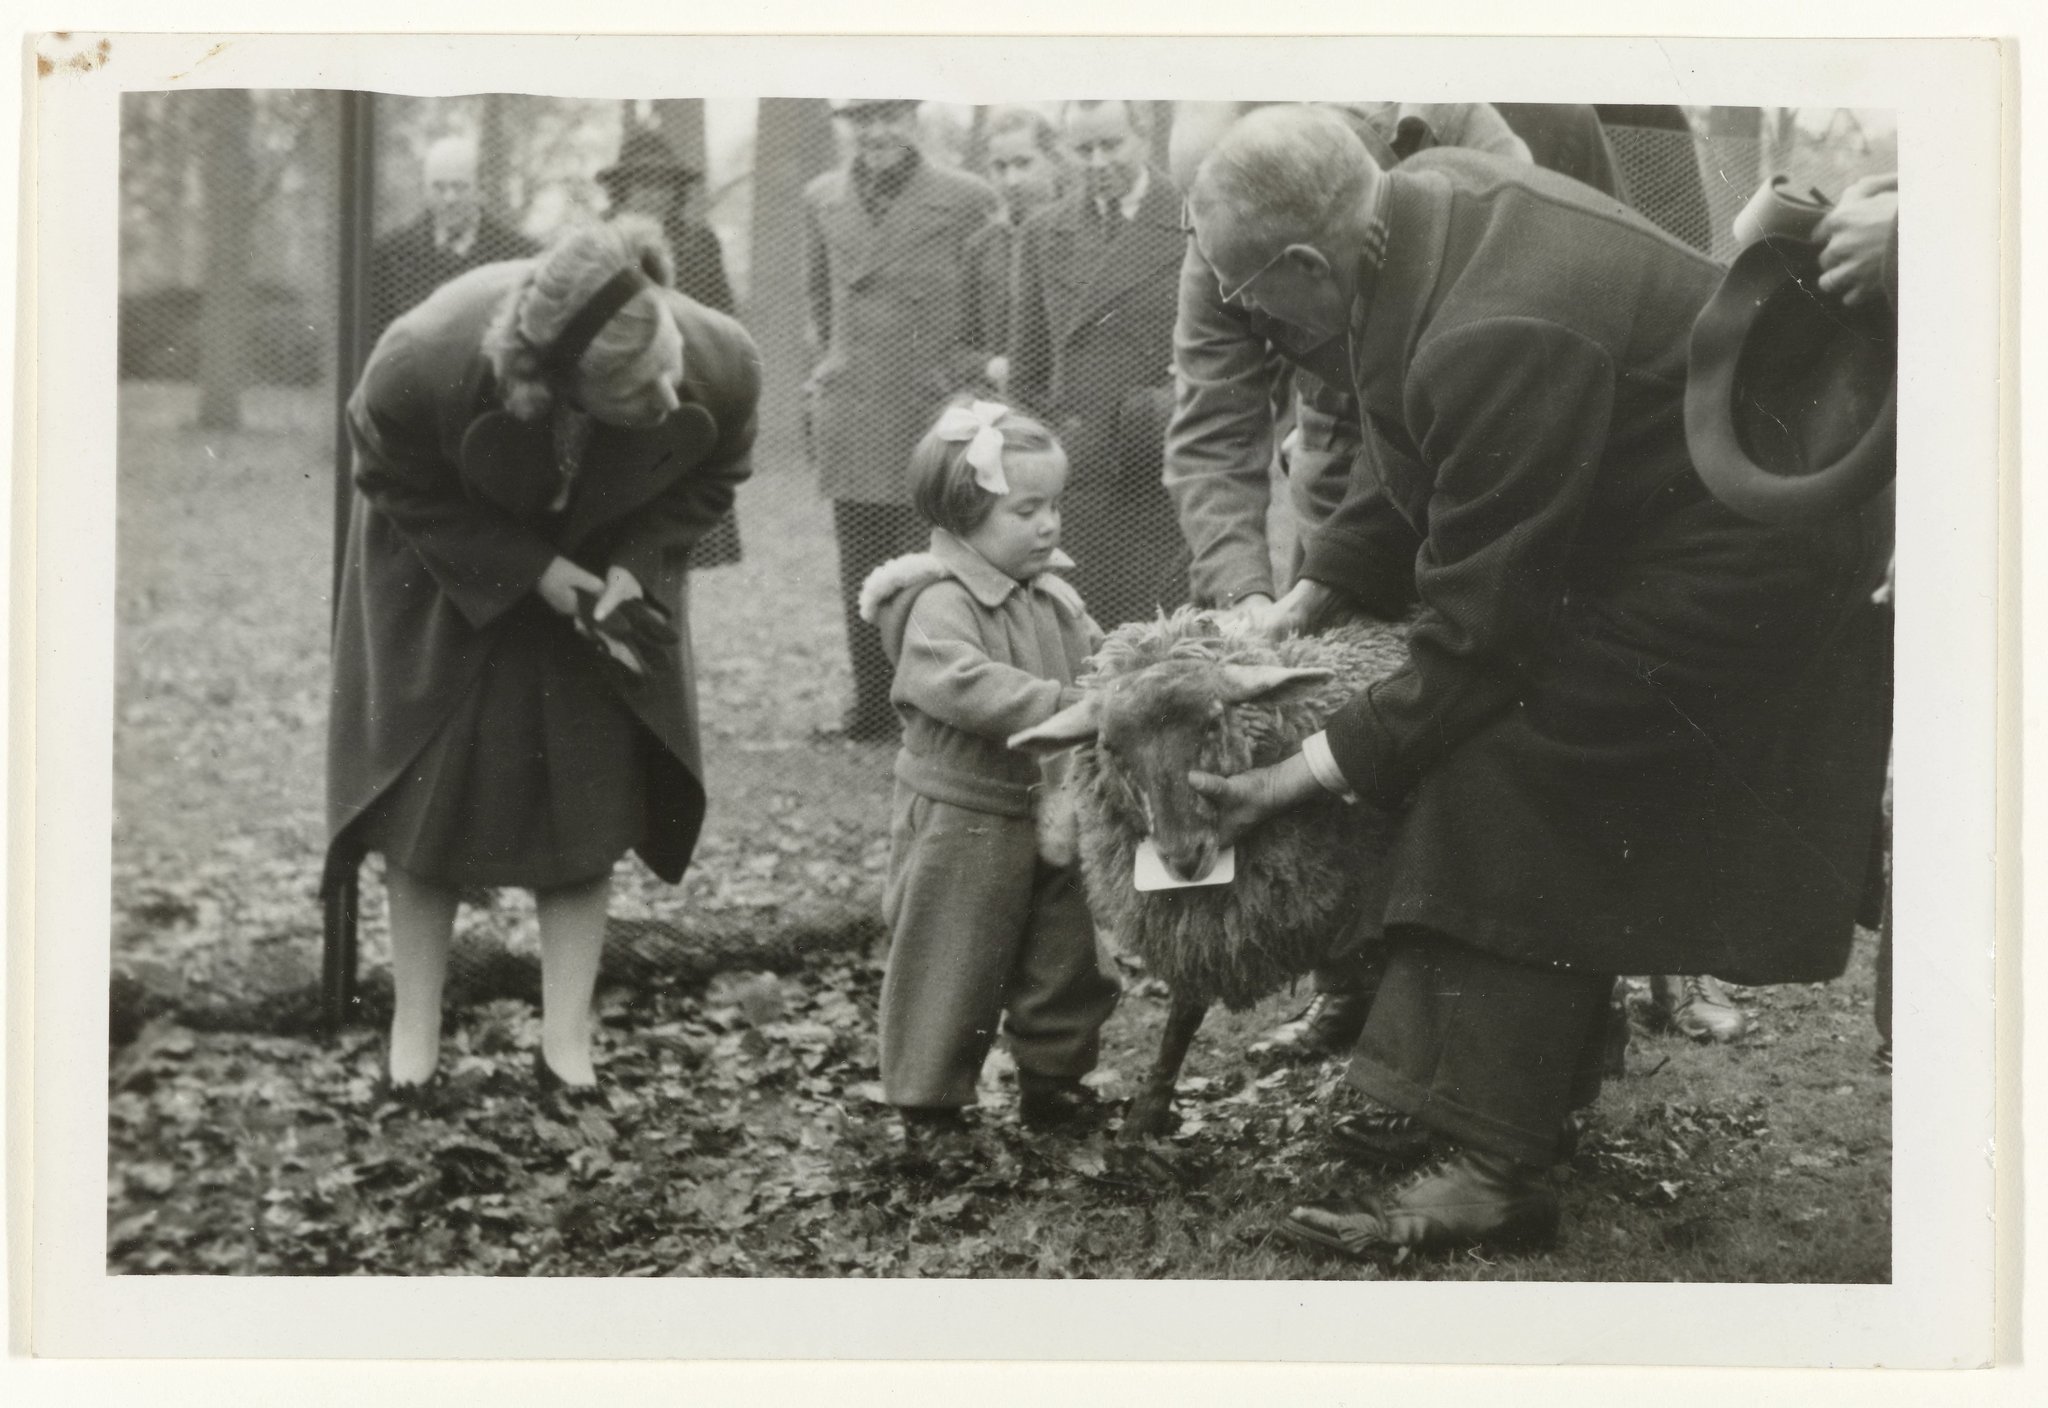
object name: photograph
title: Schapen voor de prinsesjes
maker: jaap j. herschel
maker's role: fotograaf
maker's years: 1940-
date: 1945-1946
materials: photographic support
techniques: photography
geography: soestdijk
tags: the hague, juliana of the netherlands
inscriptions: stamp: ‘COPYRIGHT / 'ANEFO' / ALGEMEEN NEDERLANDSCH FOTOBUREAU’, inscription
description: Padvinders uit Dublin hebben de prinsesjes drie schapen aangeboden. Prinses Margriet neemt met haar moeder de schapen op Paleis Soestdijk in ontvangst.